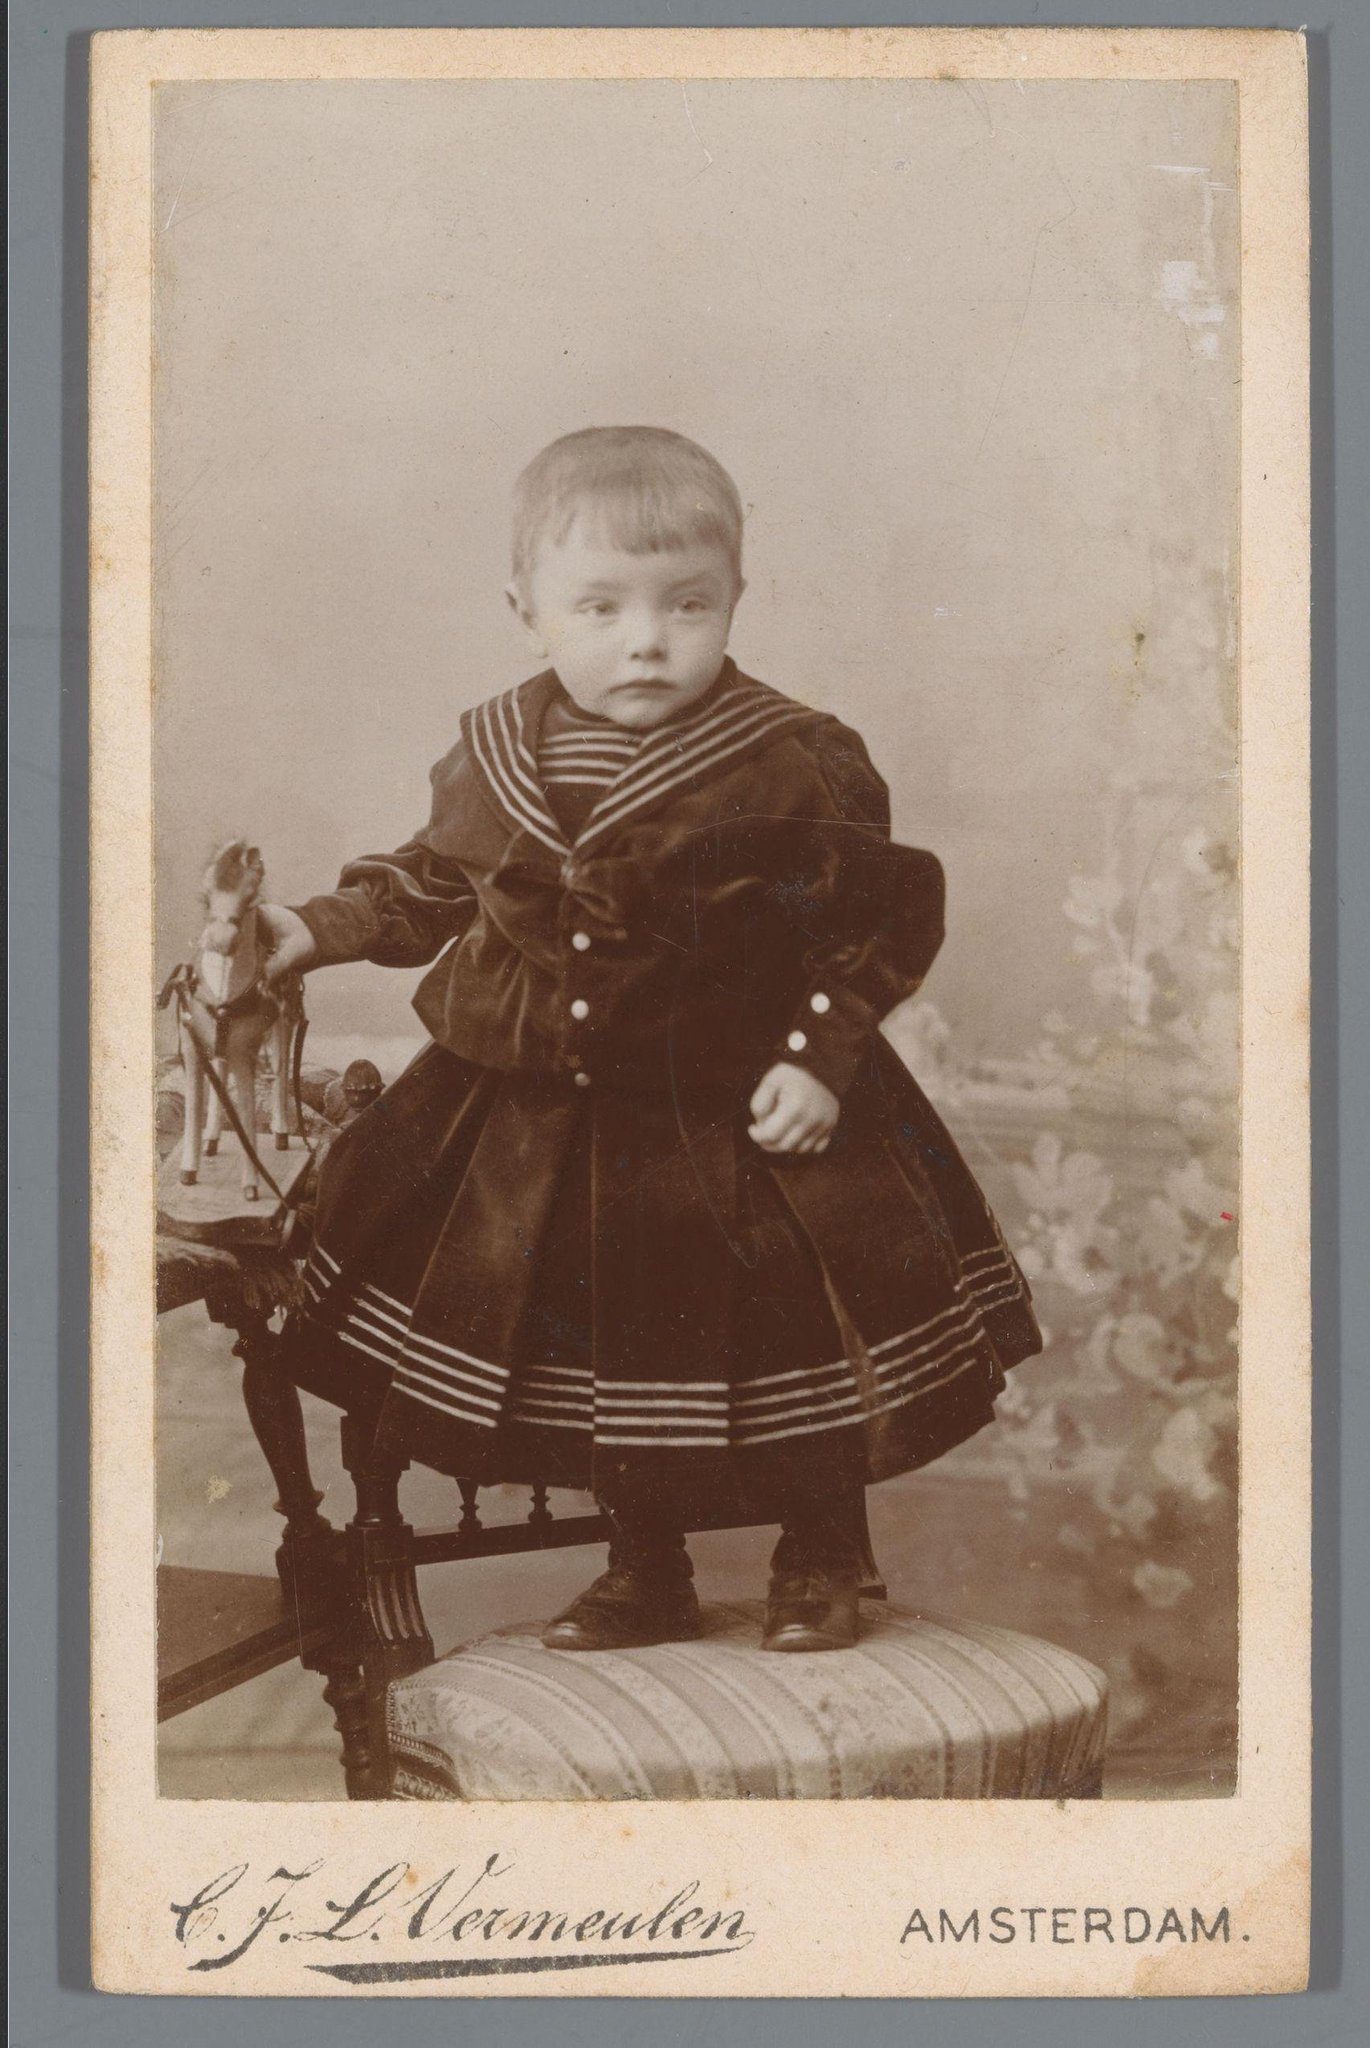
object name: carte de visite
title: Portret van een onbekend kind, staande op een stoel met speelgoed in de hand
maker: cornelis johannes lodewicus vermeulen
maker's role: fotograaf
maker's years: 1861-1936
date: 1888-1896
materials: cardboard, photographic support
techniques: collodion silver print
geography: amsterdam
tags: (playing with) toy animals, child, historical persons, chair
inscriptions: inscription: ‘C. J. L. Vermeulen/ Photographische Ateliers./ AMSTERDAM./ Heerenstraat 6 &/ Heiligenweg hoek Singel./ Specialiteit in vergrootingen.’